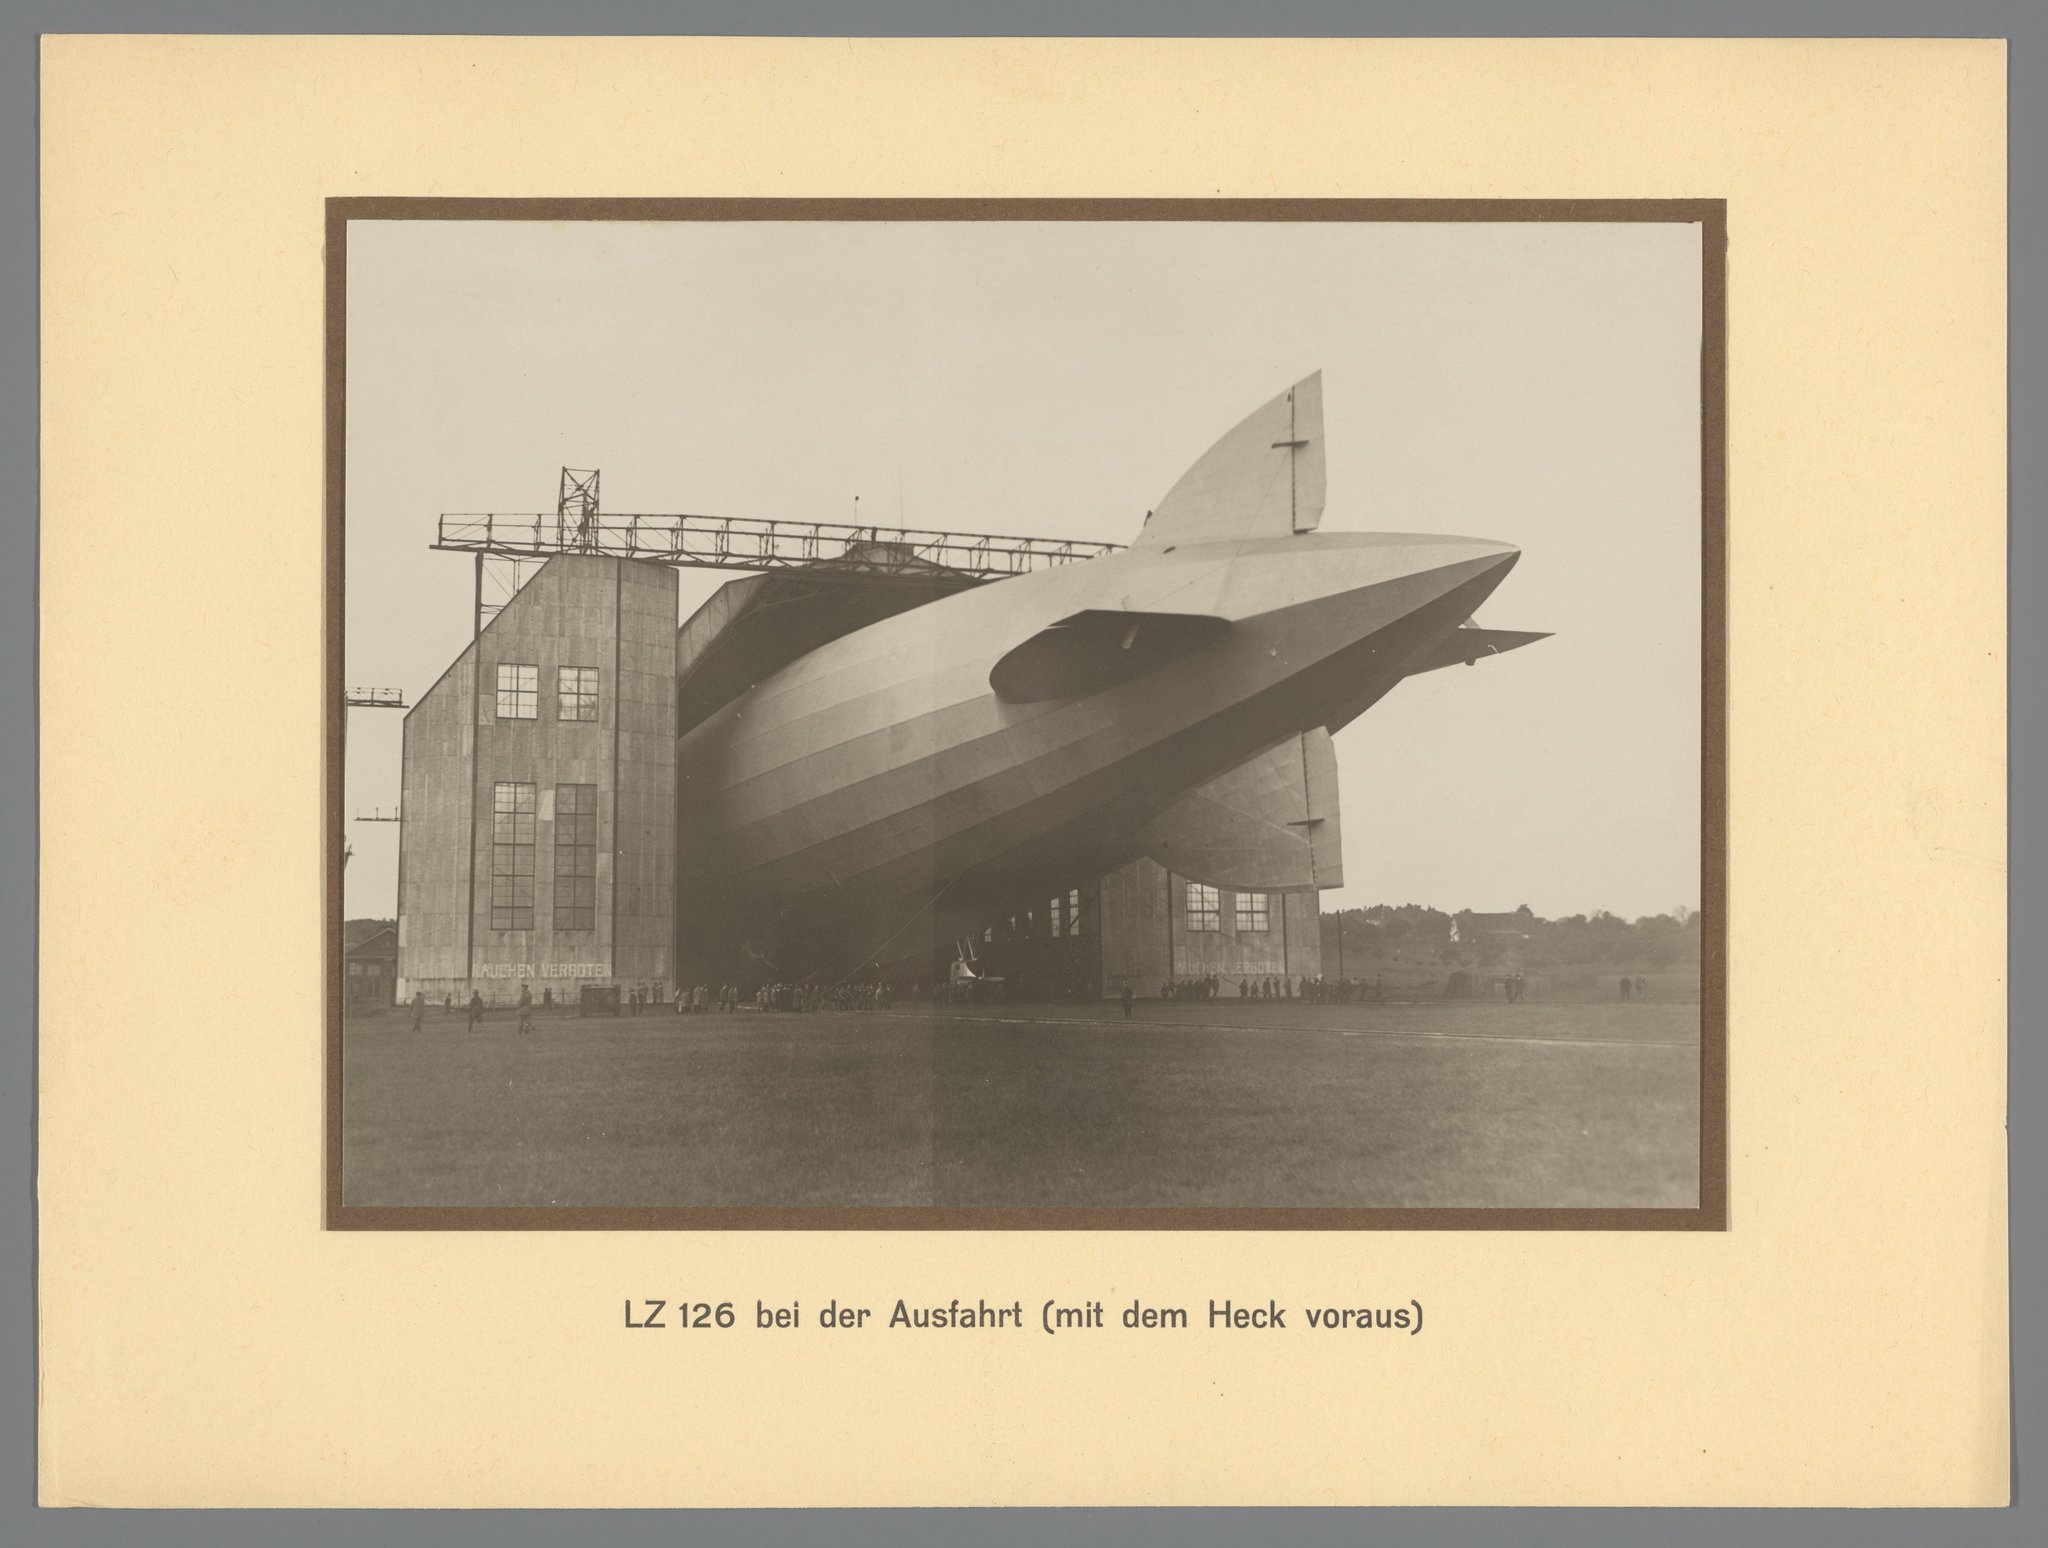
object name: photograph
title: De zeppelin achterwaarts uit de hangar gemanoevureerd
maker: Anonymous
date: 1924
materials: cardboard, photographic support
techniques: gelatin silver print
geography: friedrichshafen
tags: 46c35 airship, zeppelin, hangar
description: De zeppelin wordt achterwaarts uit de hangar gemanoevureerd. Onderdeel van een map twintig productfoto's van het Zeppelinluchtschip LZ 126.